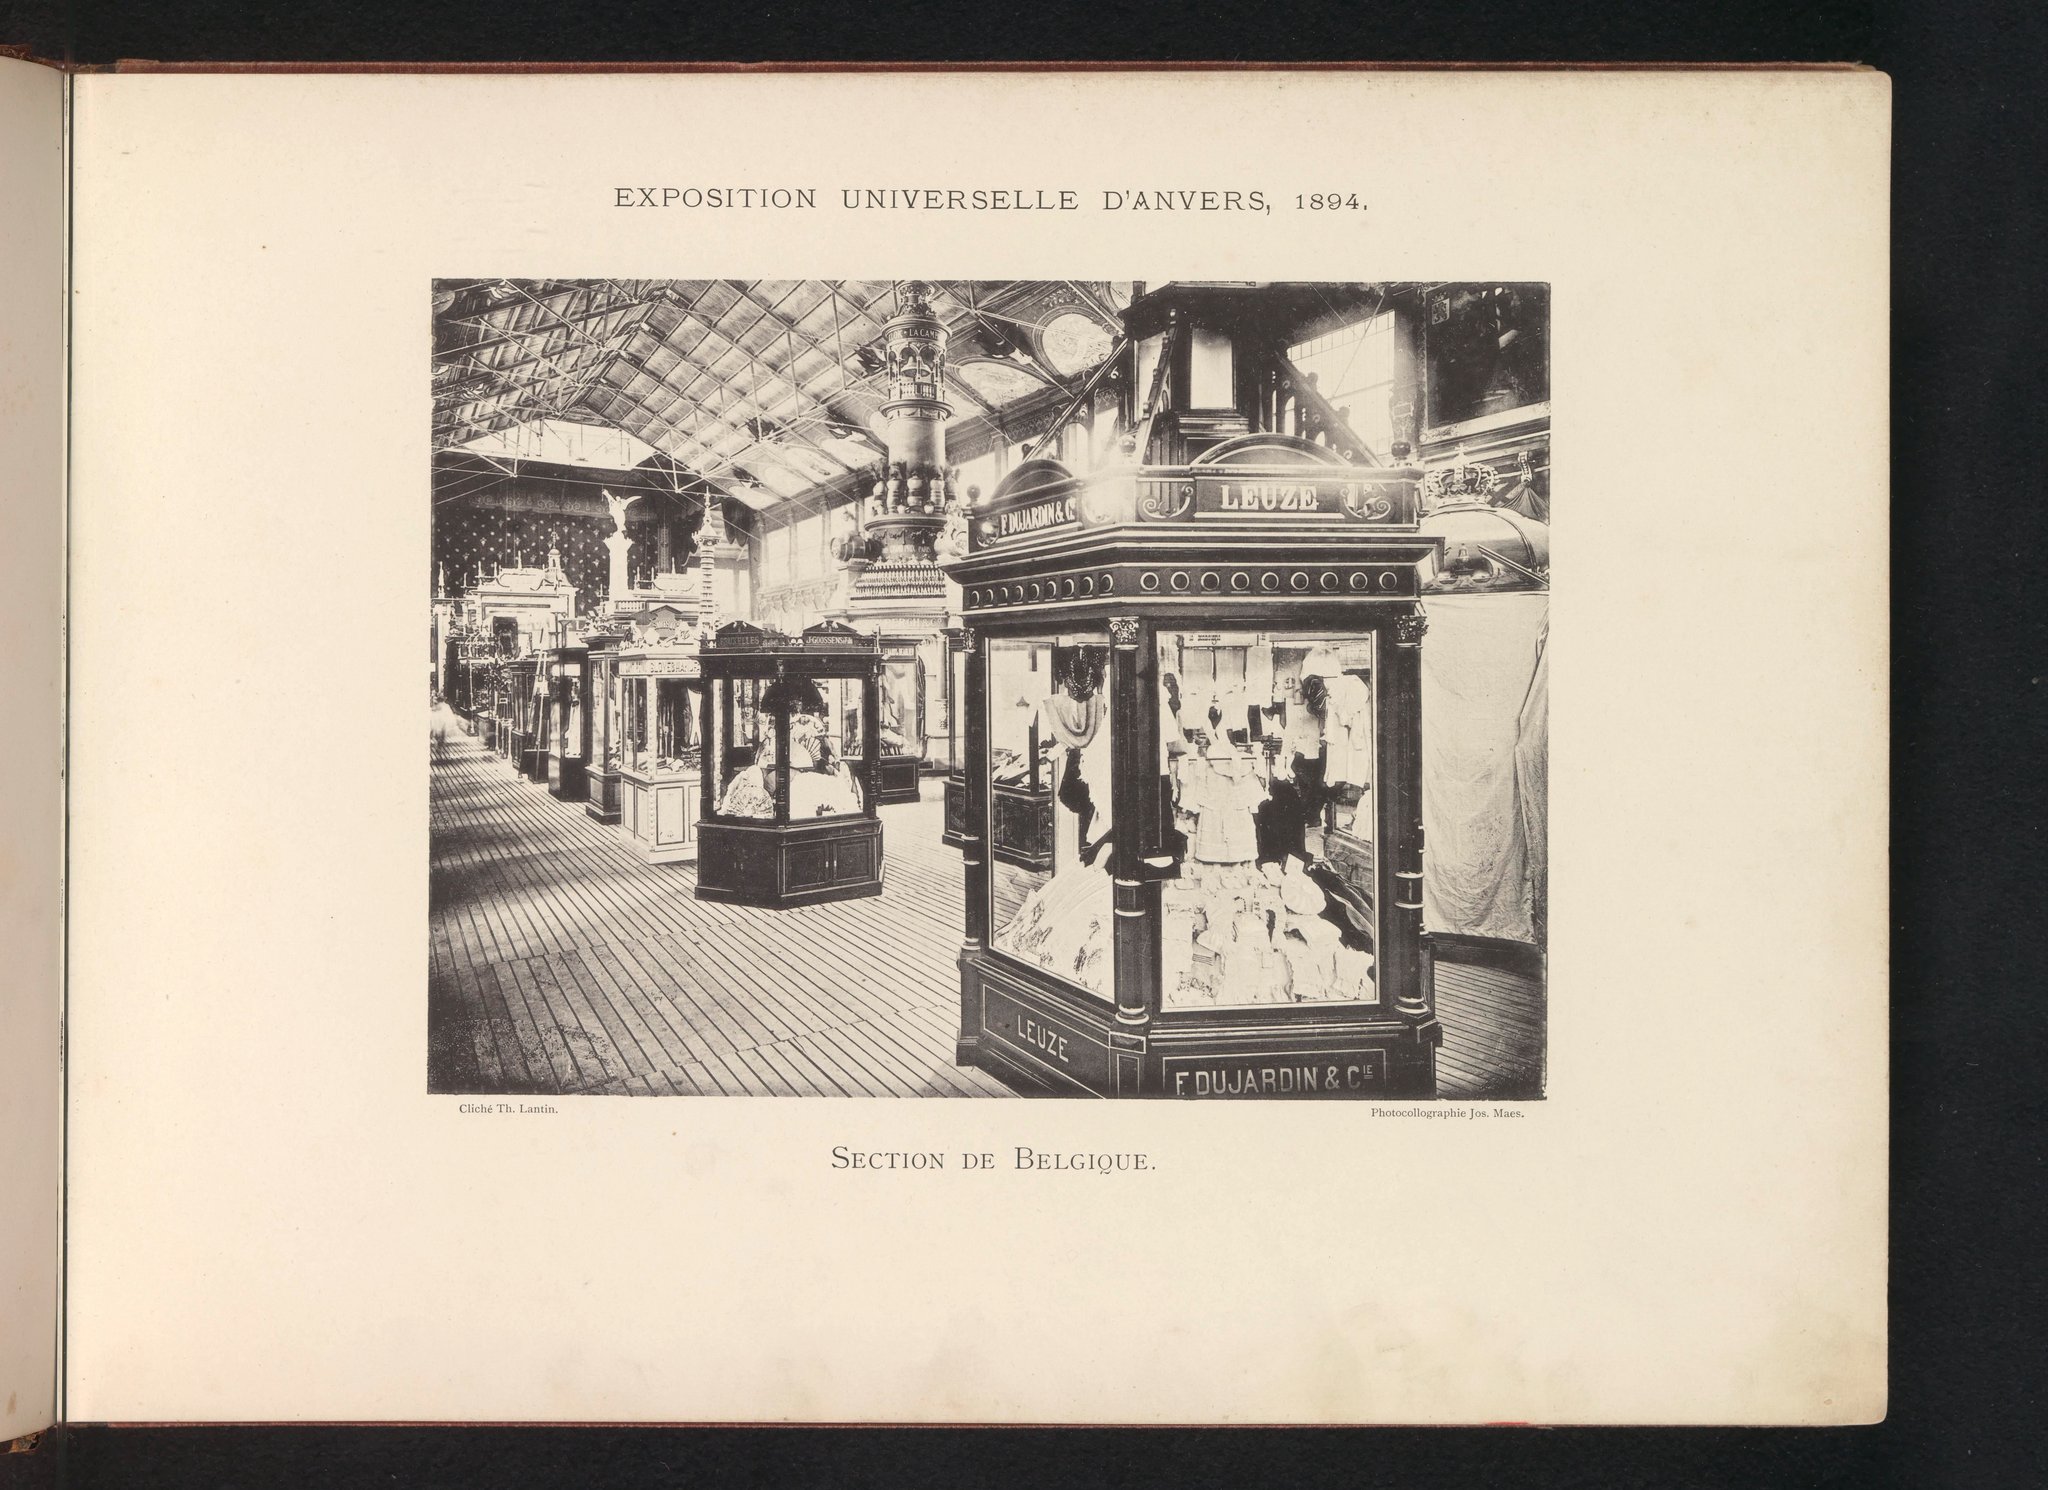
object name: page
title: Expositie van Belgische objecten tijdens de wereldtentoonstelling te Antwerpen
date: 1894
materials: paper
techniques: photograph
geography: antwerp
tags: world fair, world exhibition, collection, exhibition, show